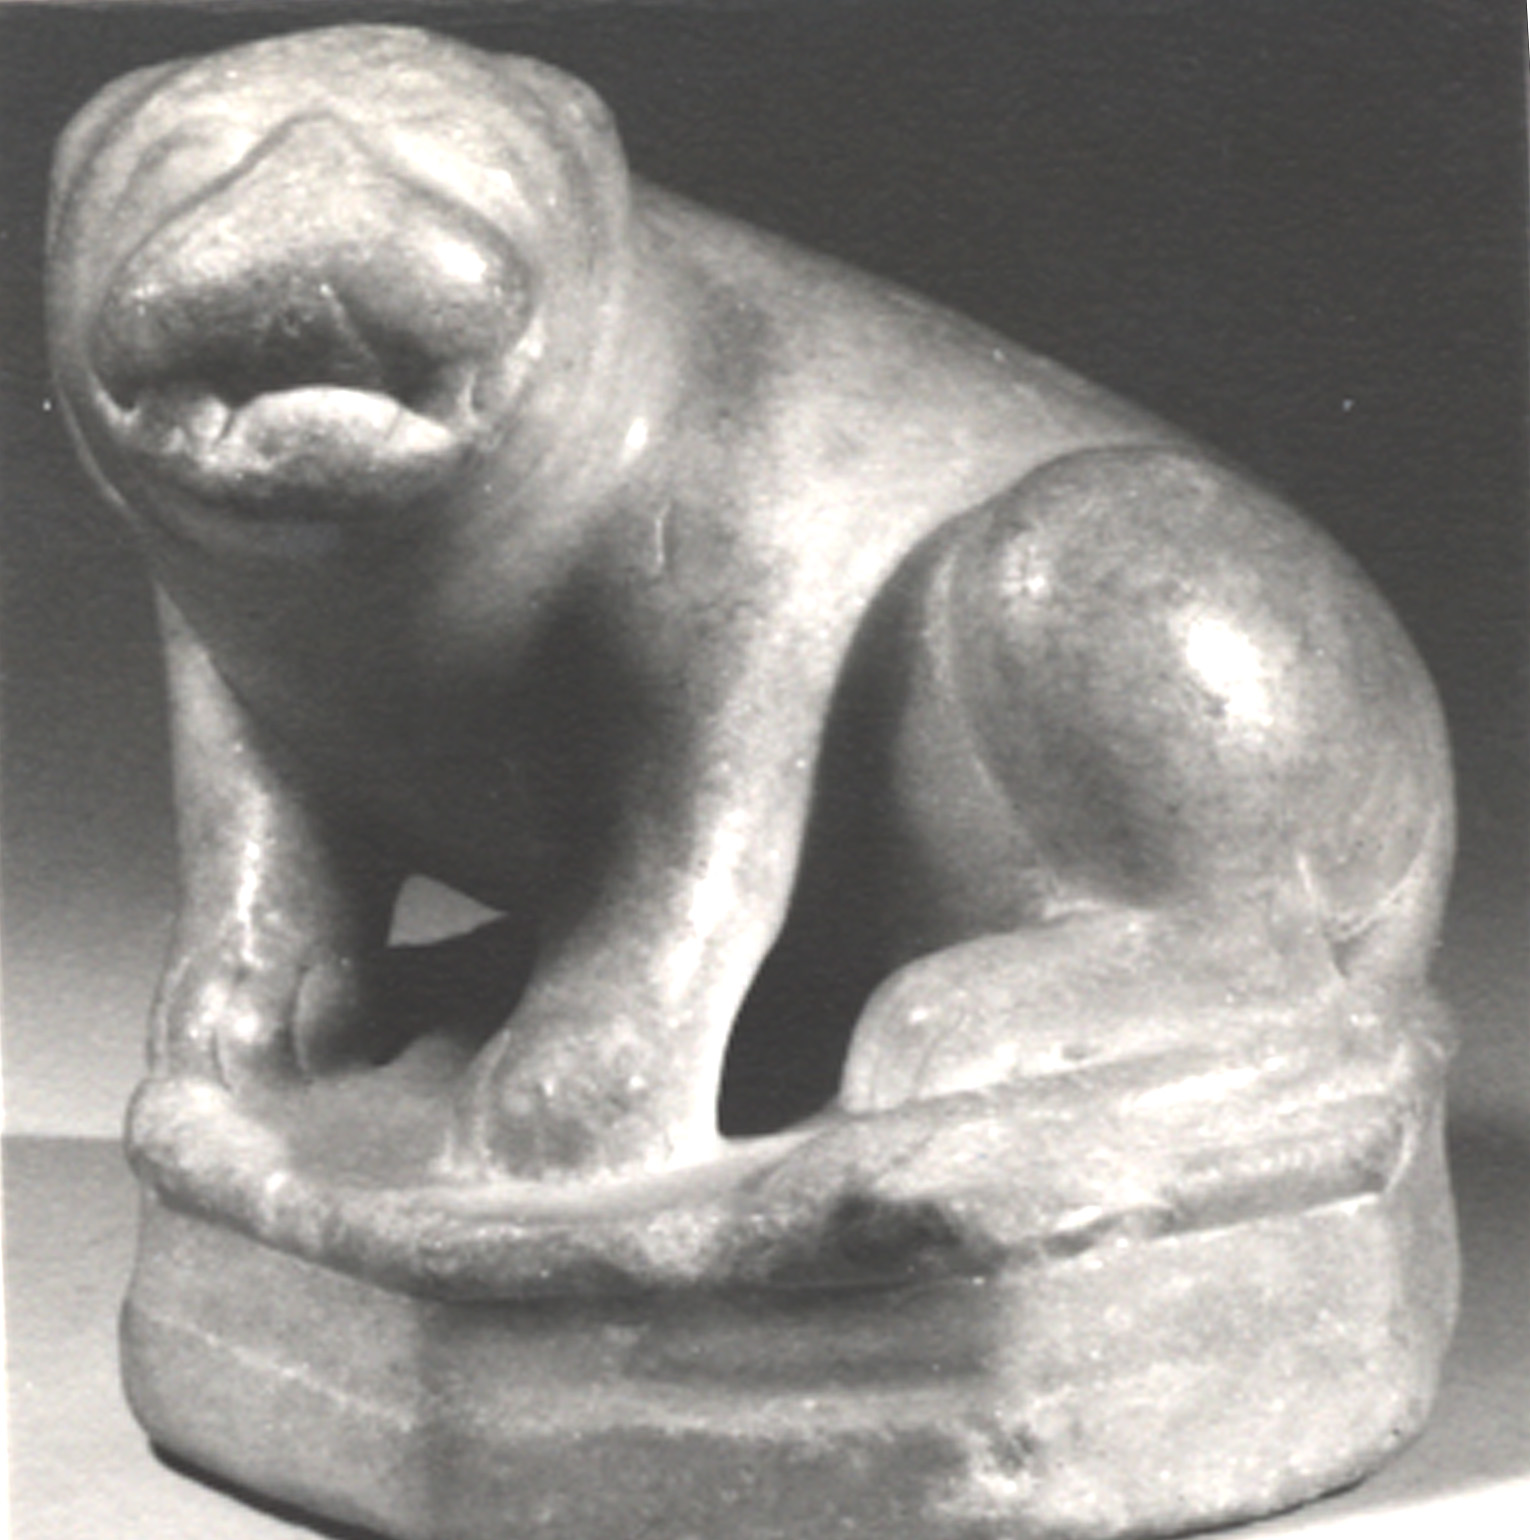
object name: figurine, composite animal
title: Figurine of a Composite Animal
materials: marble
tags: animals